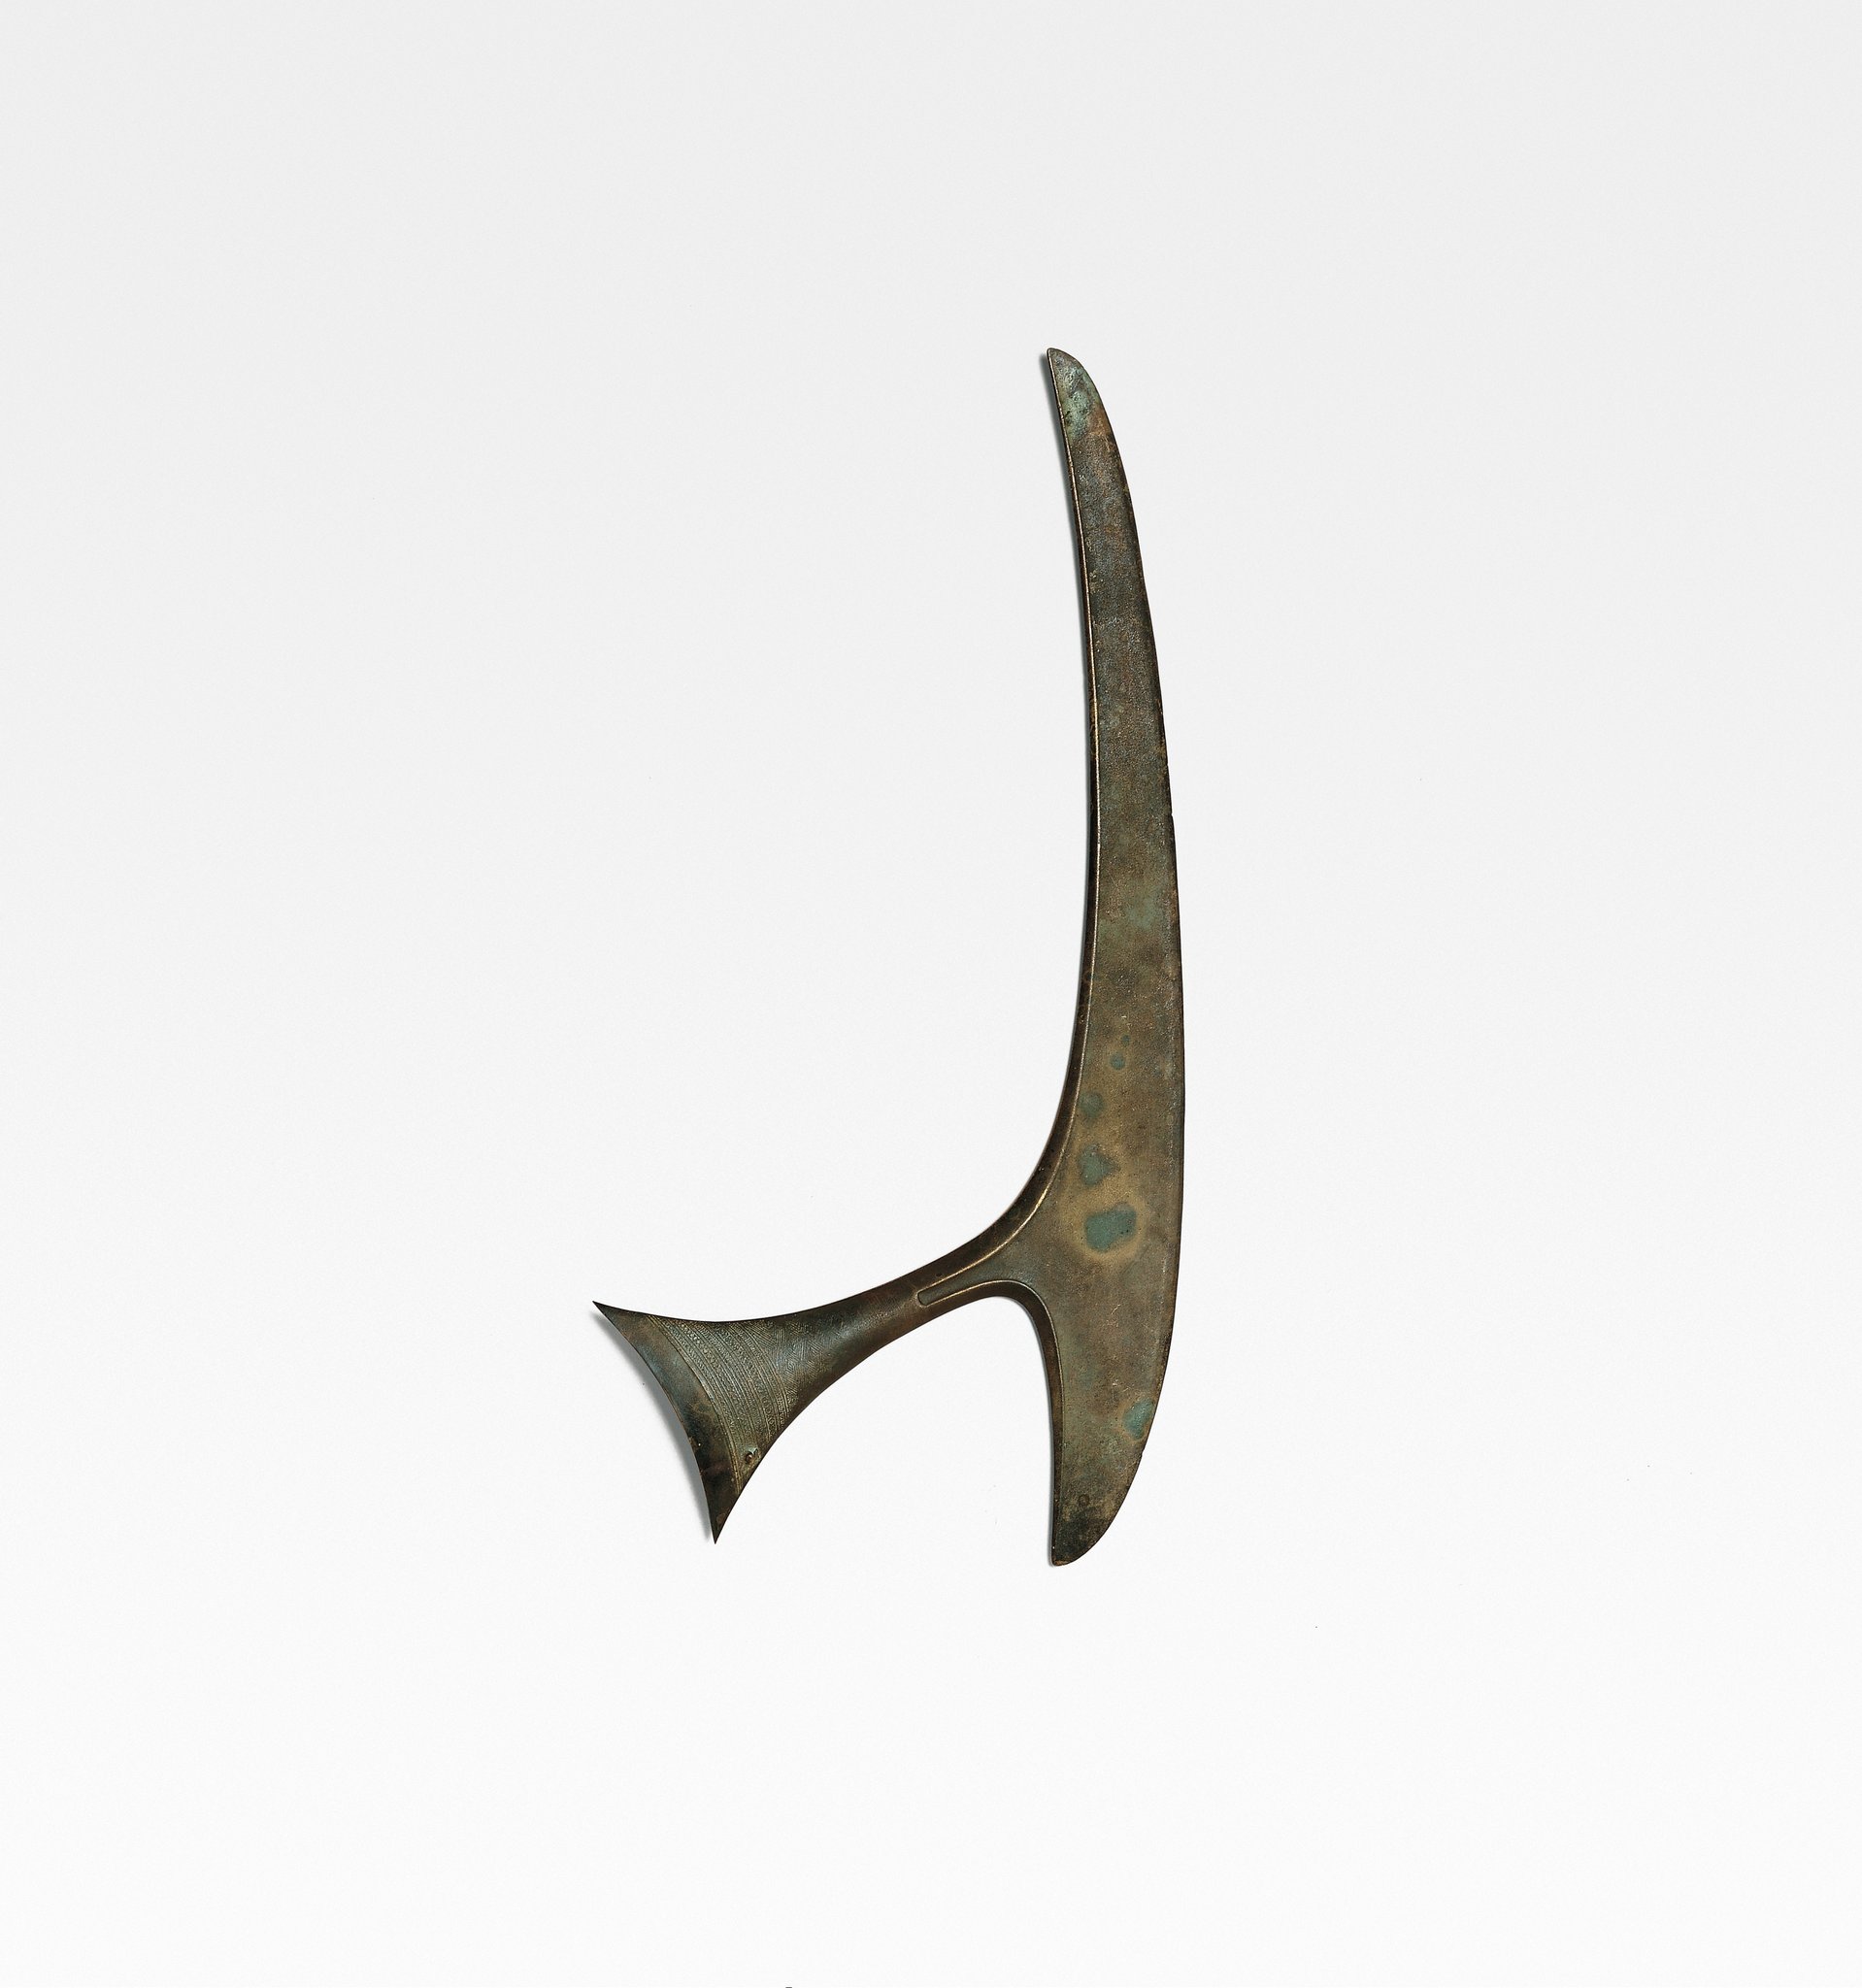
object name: ax head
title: Crescent-Shaped Ax Head (Chandrasa)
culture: indonesian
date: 500 BCE-300 CE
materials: bronze